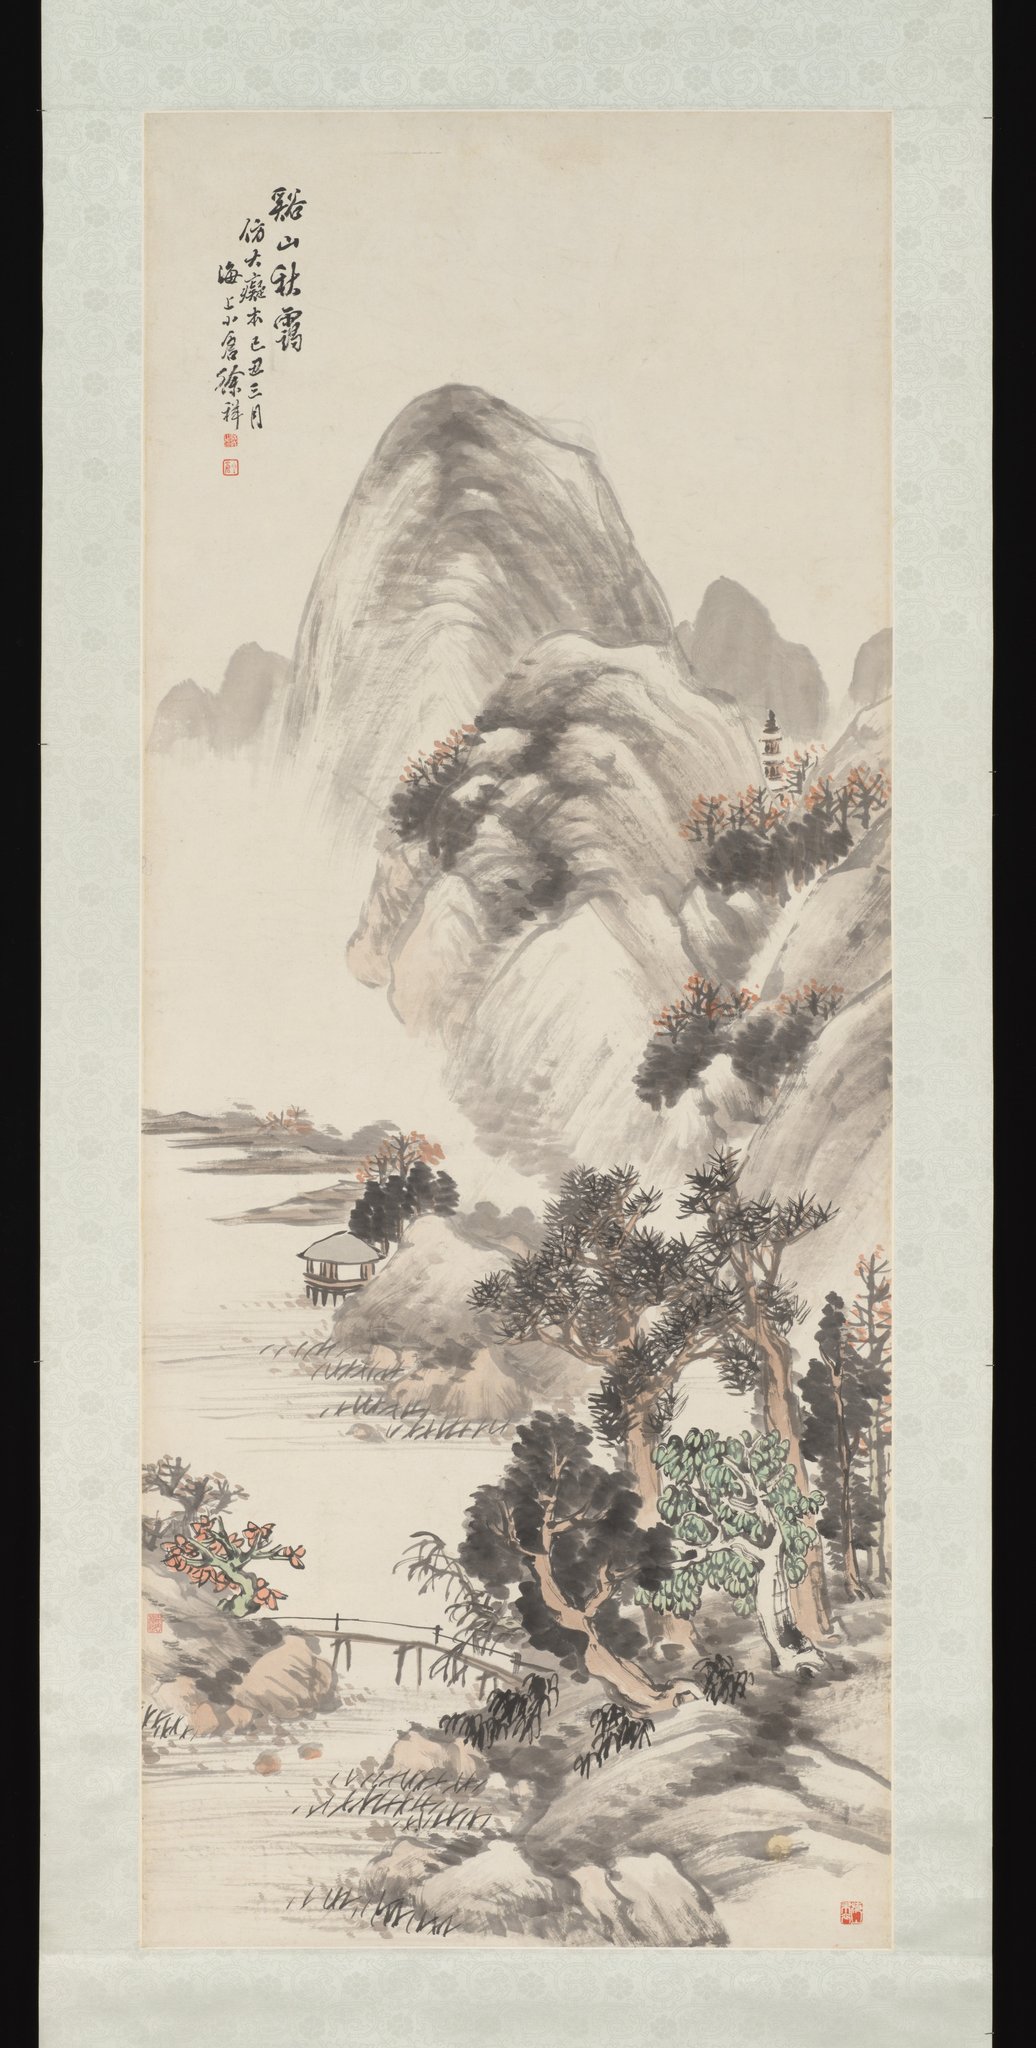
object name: hanging scroll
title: Landscape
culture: chinese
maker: xu xiang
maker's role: artist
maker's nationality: chinese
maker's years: 1850-1899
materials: ink, paper